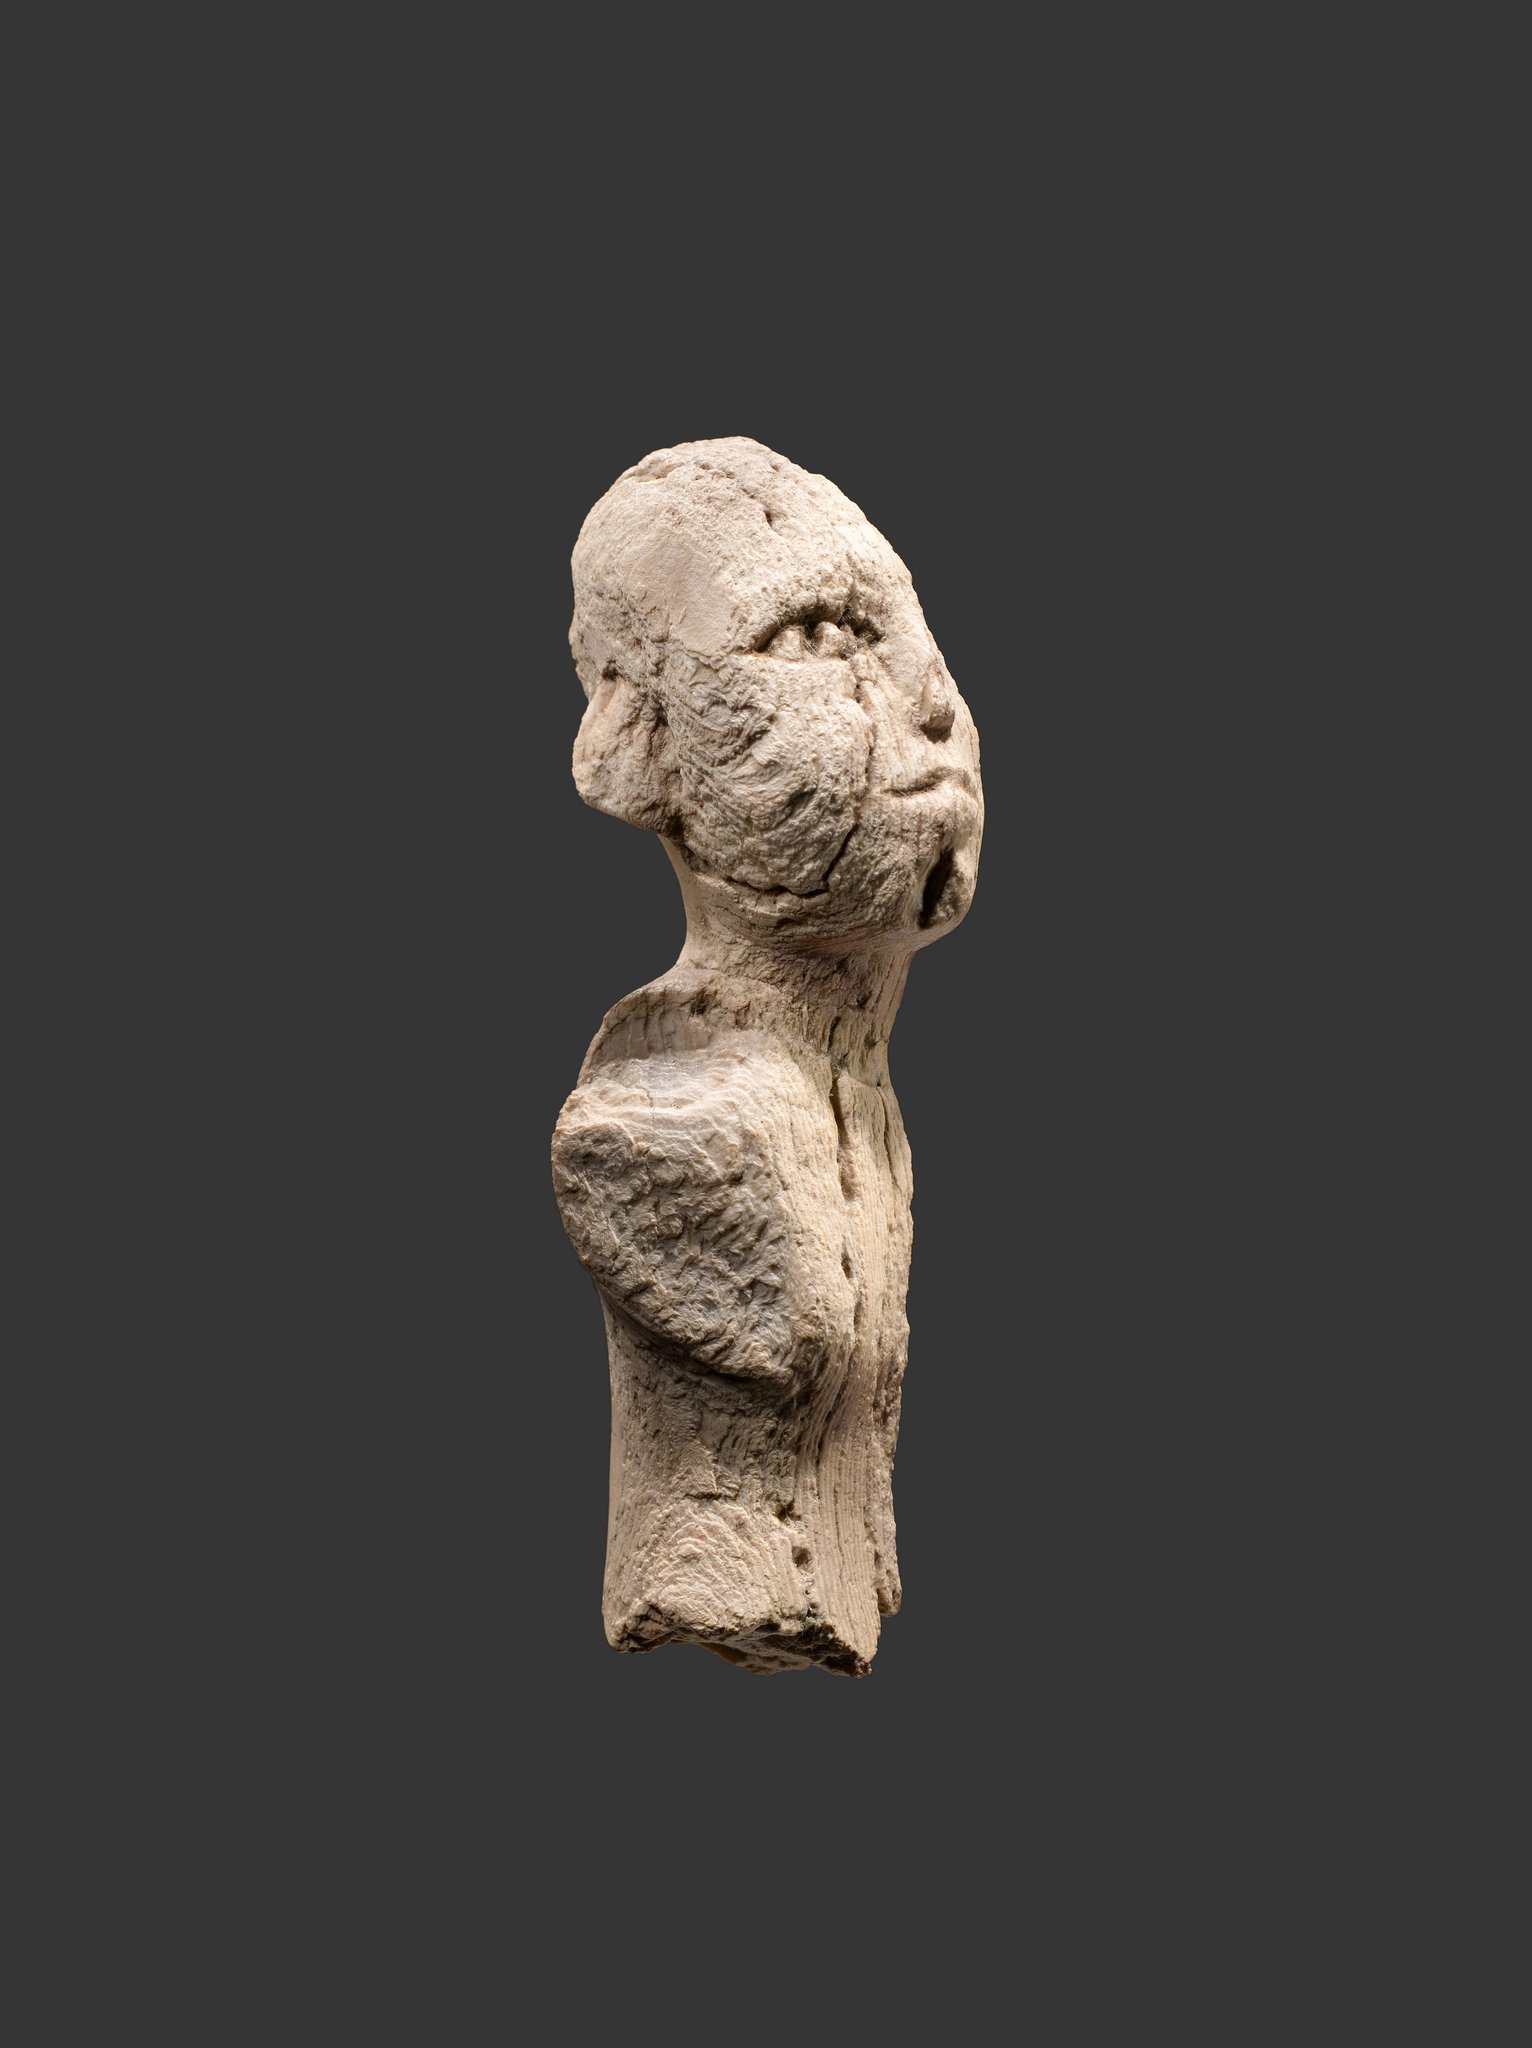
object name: statuette fragment, male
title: Human figure, possibly male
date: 3300-3100 BCE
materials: ivory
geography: egypt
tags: men